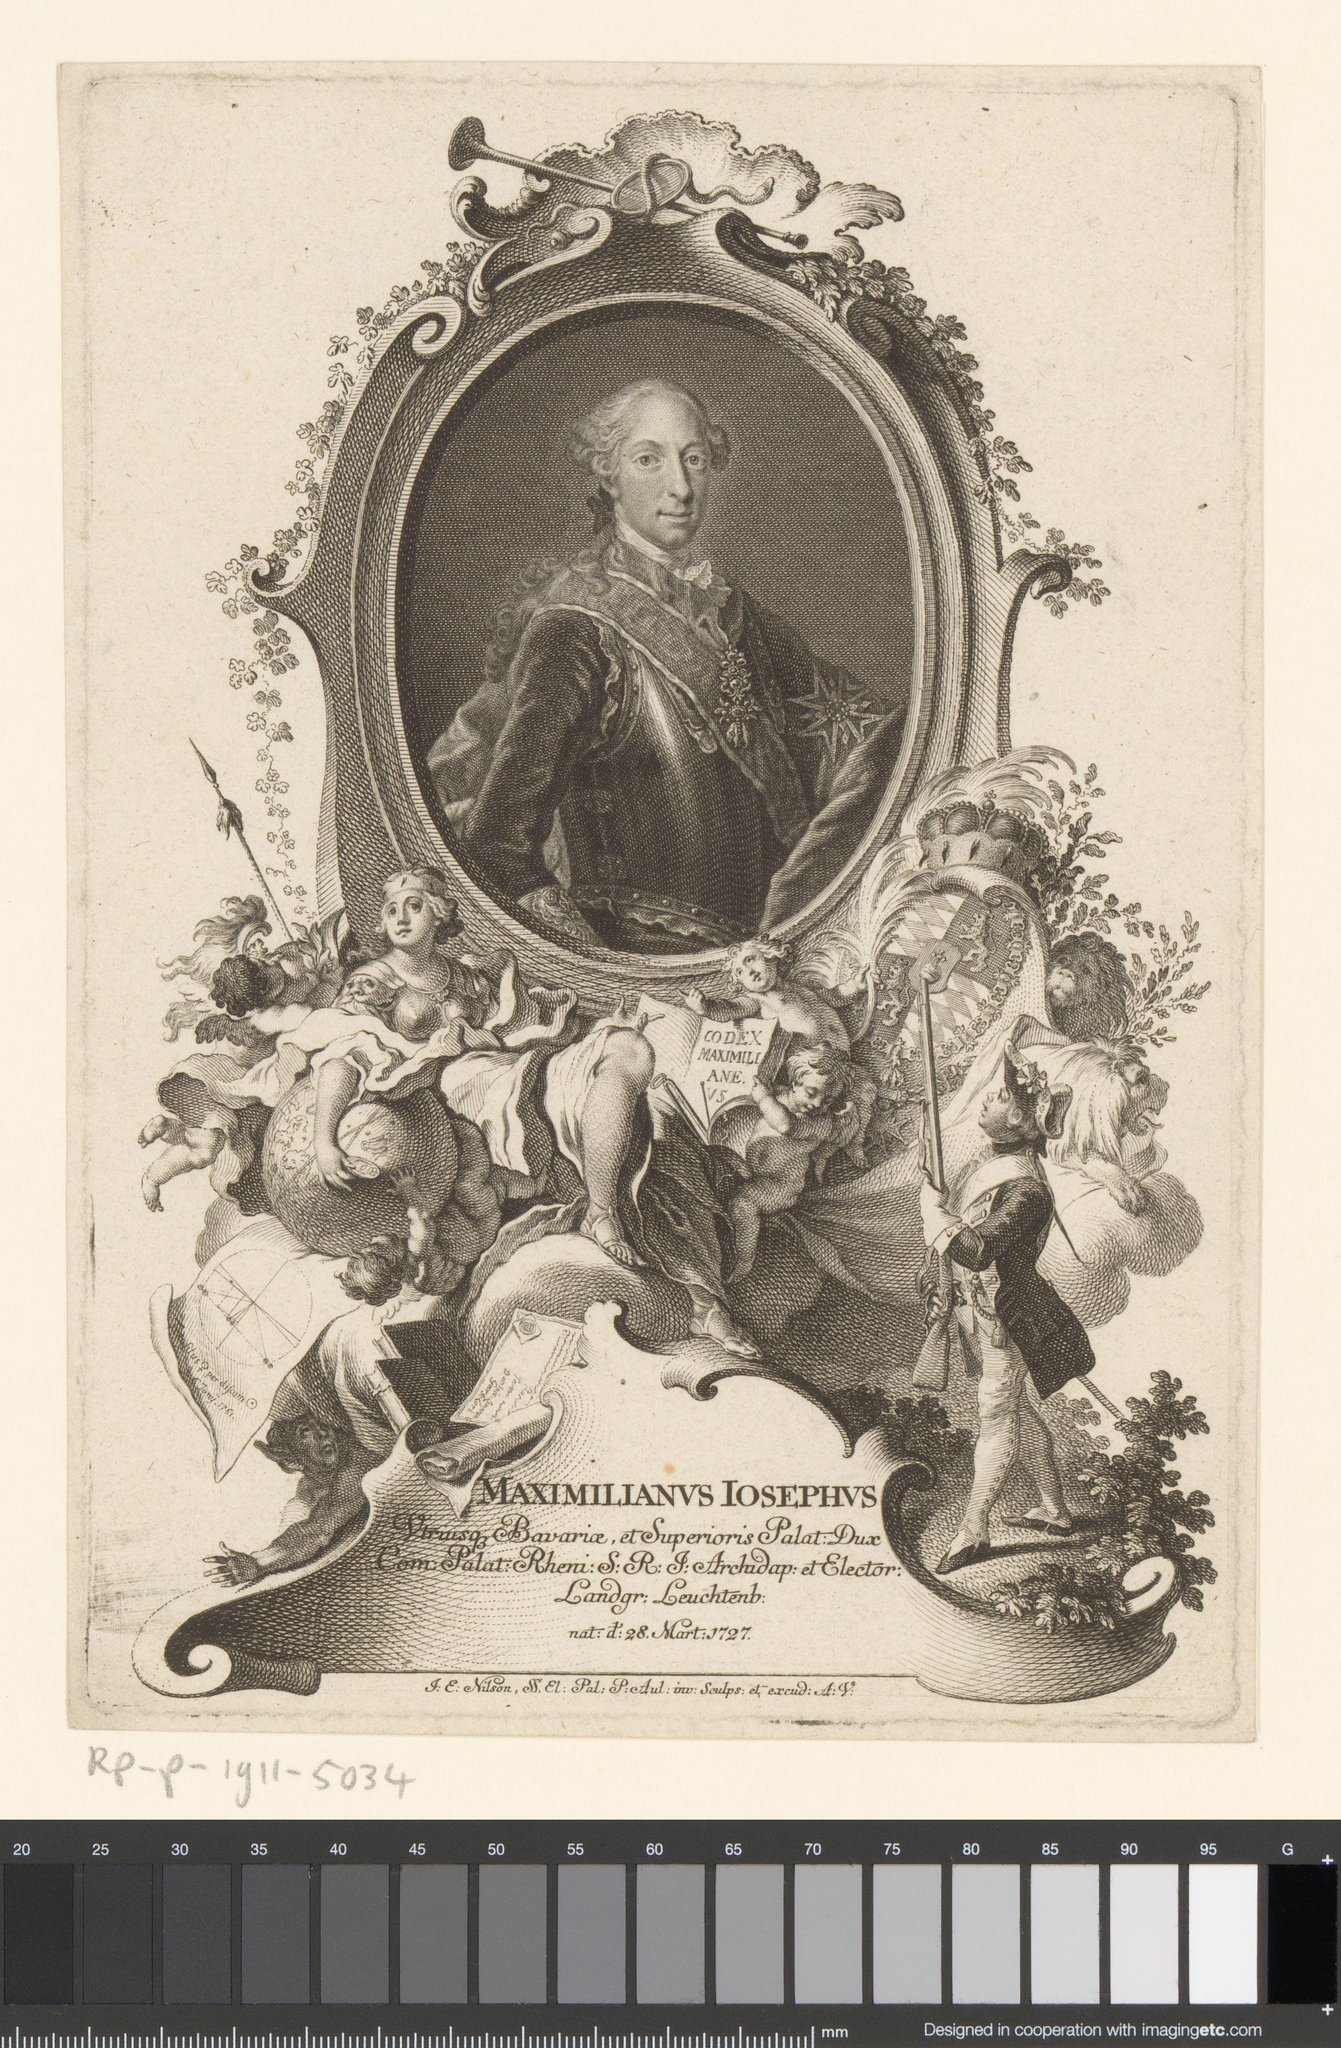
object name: print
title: Portret van Maximiliaan III Jozef van Beieren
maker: johann esaias nilson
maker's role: draughtsman, print maker, publisher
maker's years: 1721-1788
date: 1761-1788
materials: paper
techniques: engraving, etching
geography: augsburg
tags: armour, historical persons, measuring, the soldier; the soldier's life, fame; 'fama', 'fama buona', 'fama chiara' (ripa), globe, beasts of prey, predatory animals: lion, baton of general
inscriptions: collector's mark: Lugt 2228